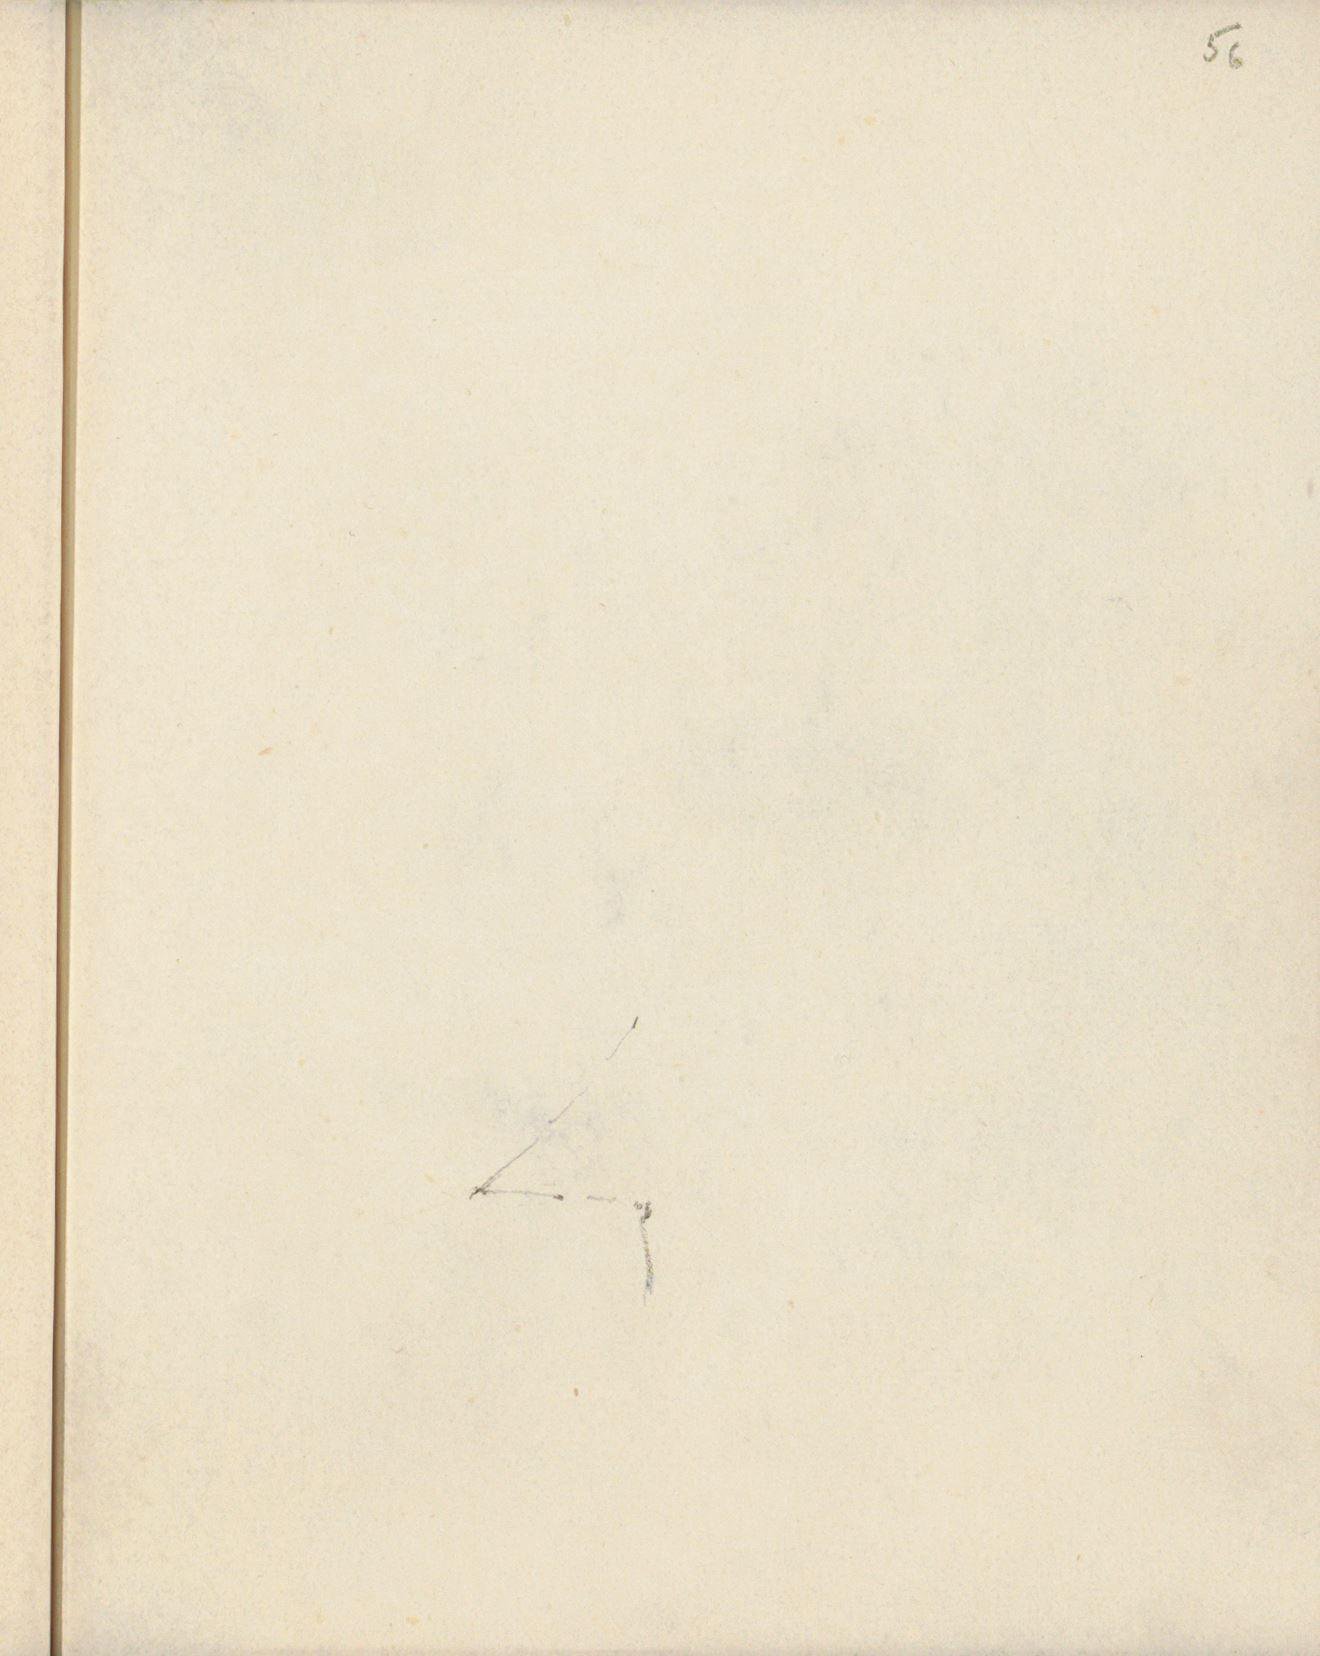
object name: sketchbook leaf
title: Studie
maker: alfred william rich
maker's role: draughtsman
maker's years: 1856-1921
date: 1892-1893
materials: paper, pencil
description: Blad 56 recto uit een schetsboek met 86 bladen.